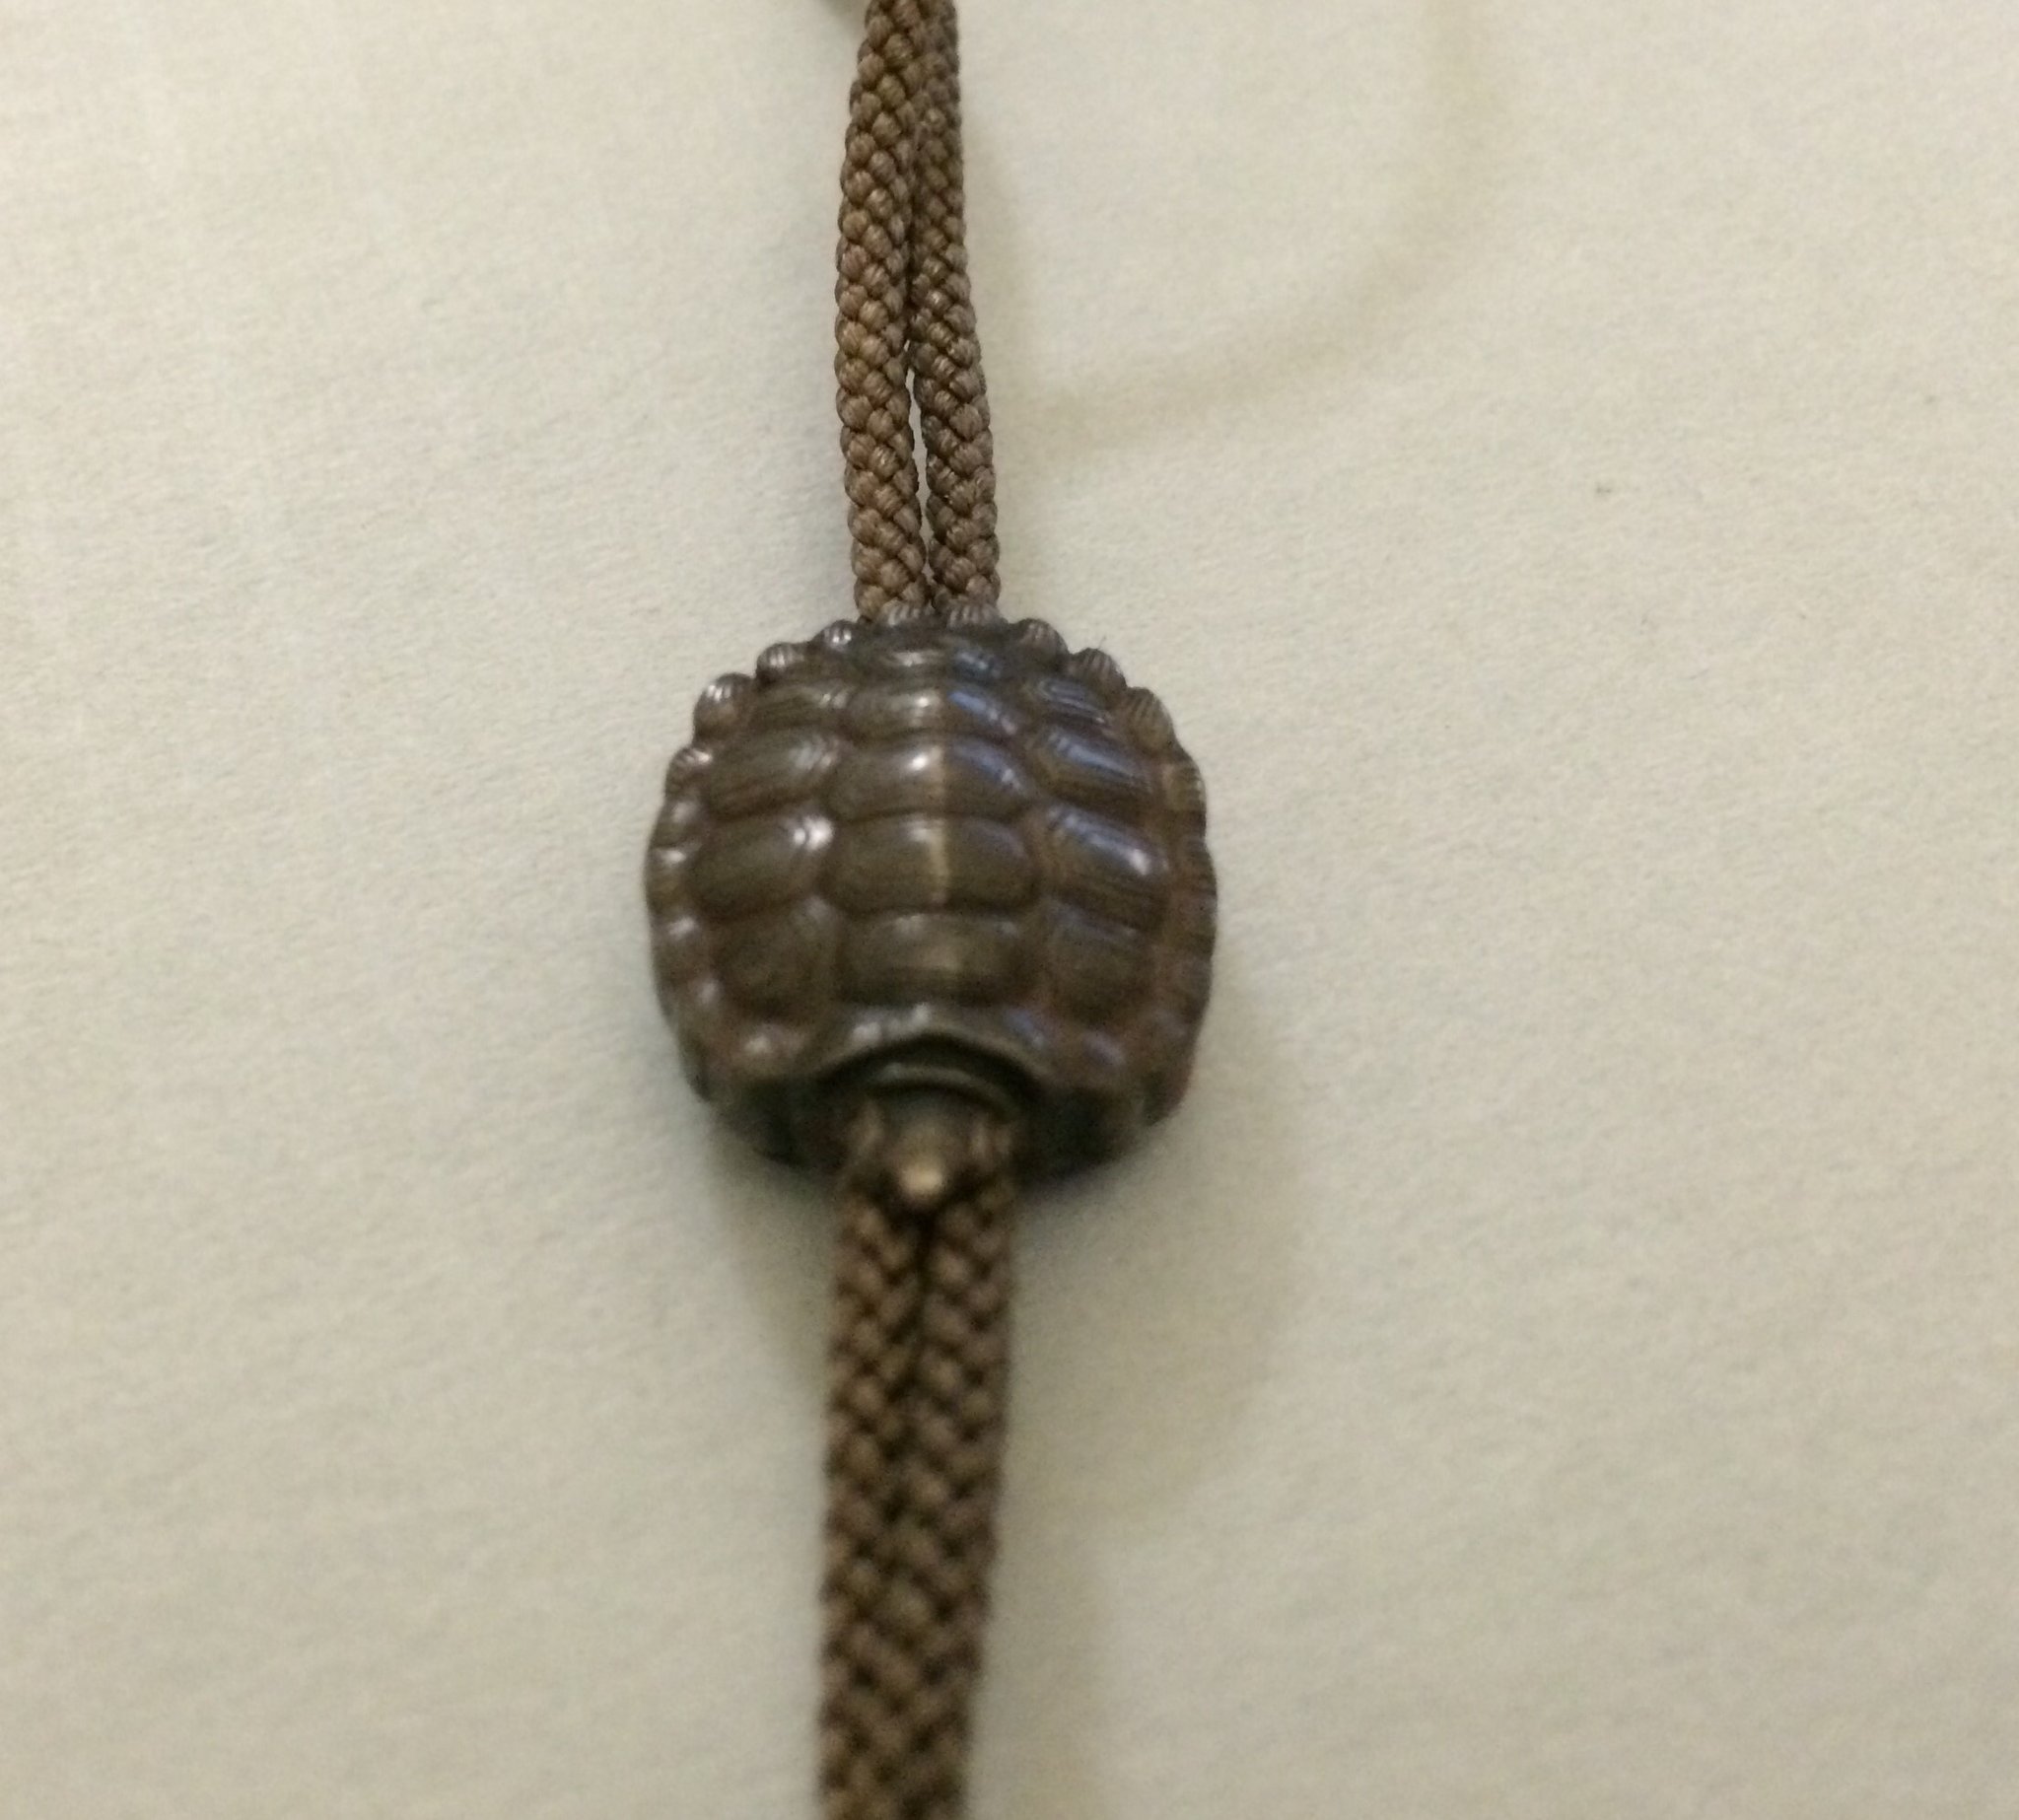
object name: ojime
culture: japanese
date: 1801-1900